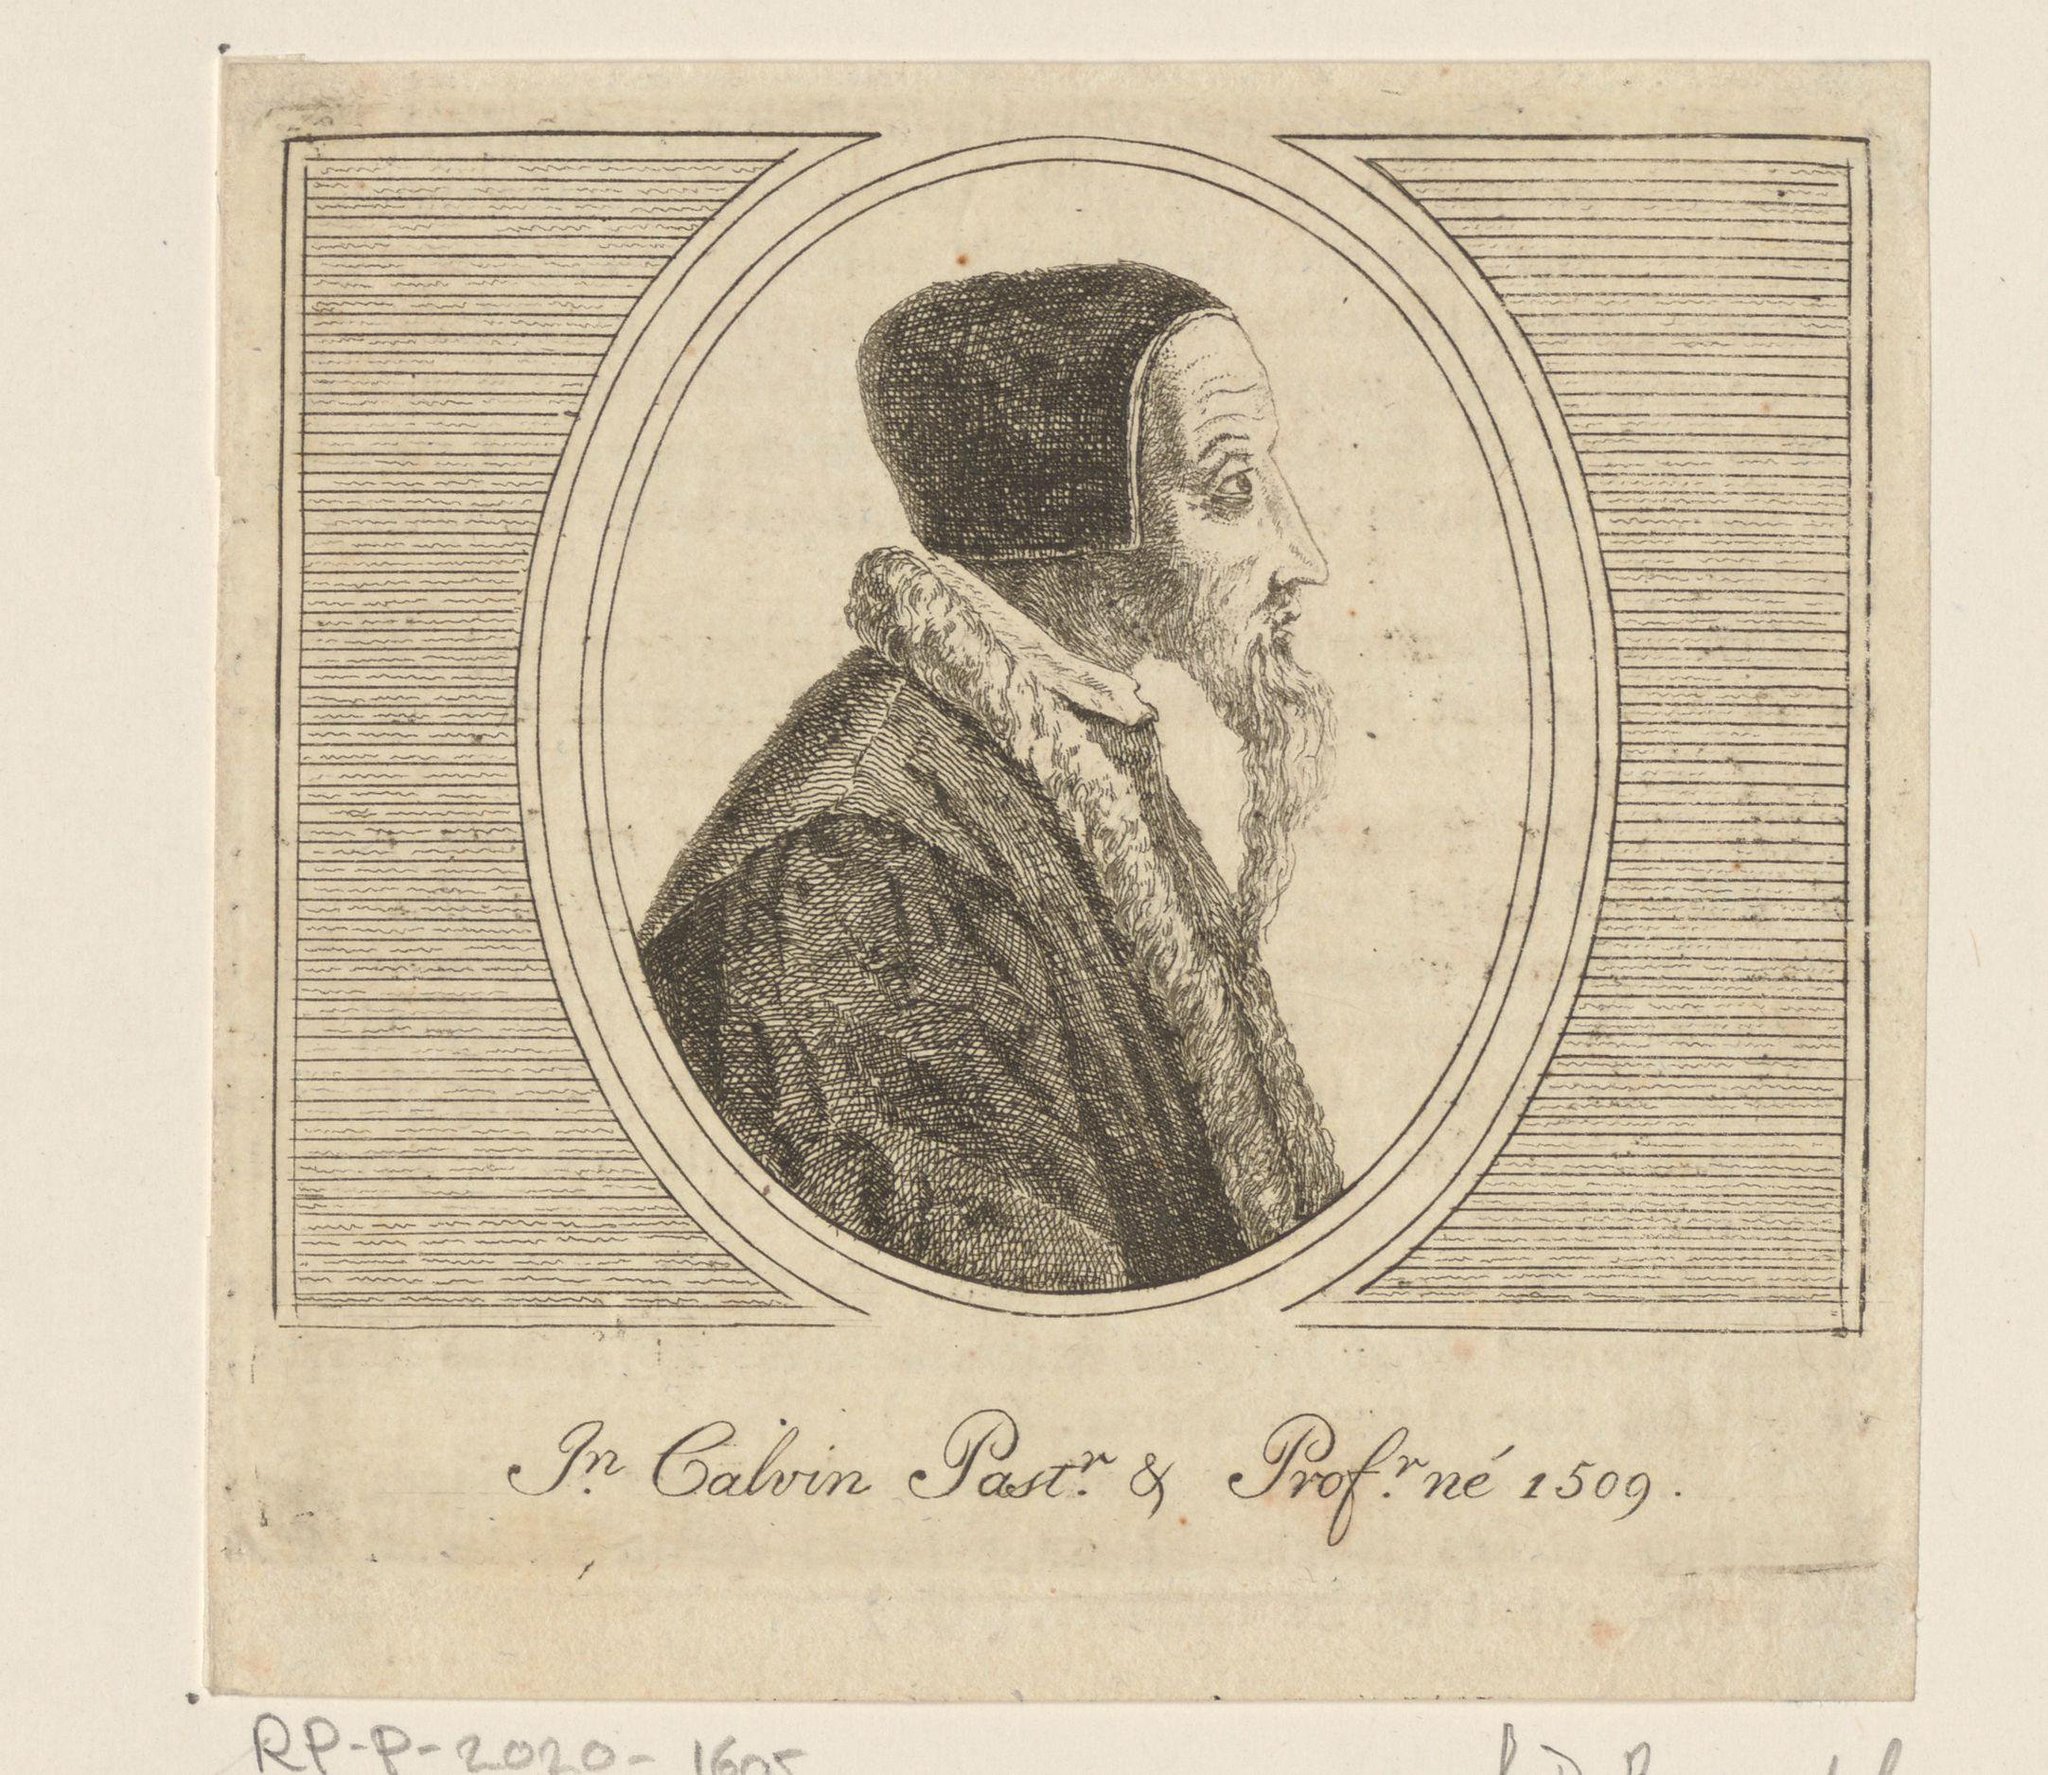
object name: book illustration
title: Portret van Johannes Calvijn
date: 1815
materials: paper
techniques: etching, letterpress printing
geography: geneva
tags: historical persons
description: Prent uit: Grenus-Saladin, François Théodore Louis. Fragmens biographiques et historiques, extraits des registres du Conseil d'Etat de la République de Genève (...). Genève: Magnet en Abraham Cherbuliez, 1815, p. 17.